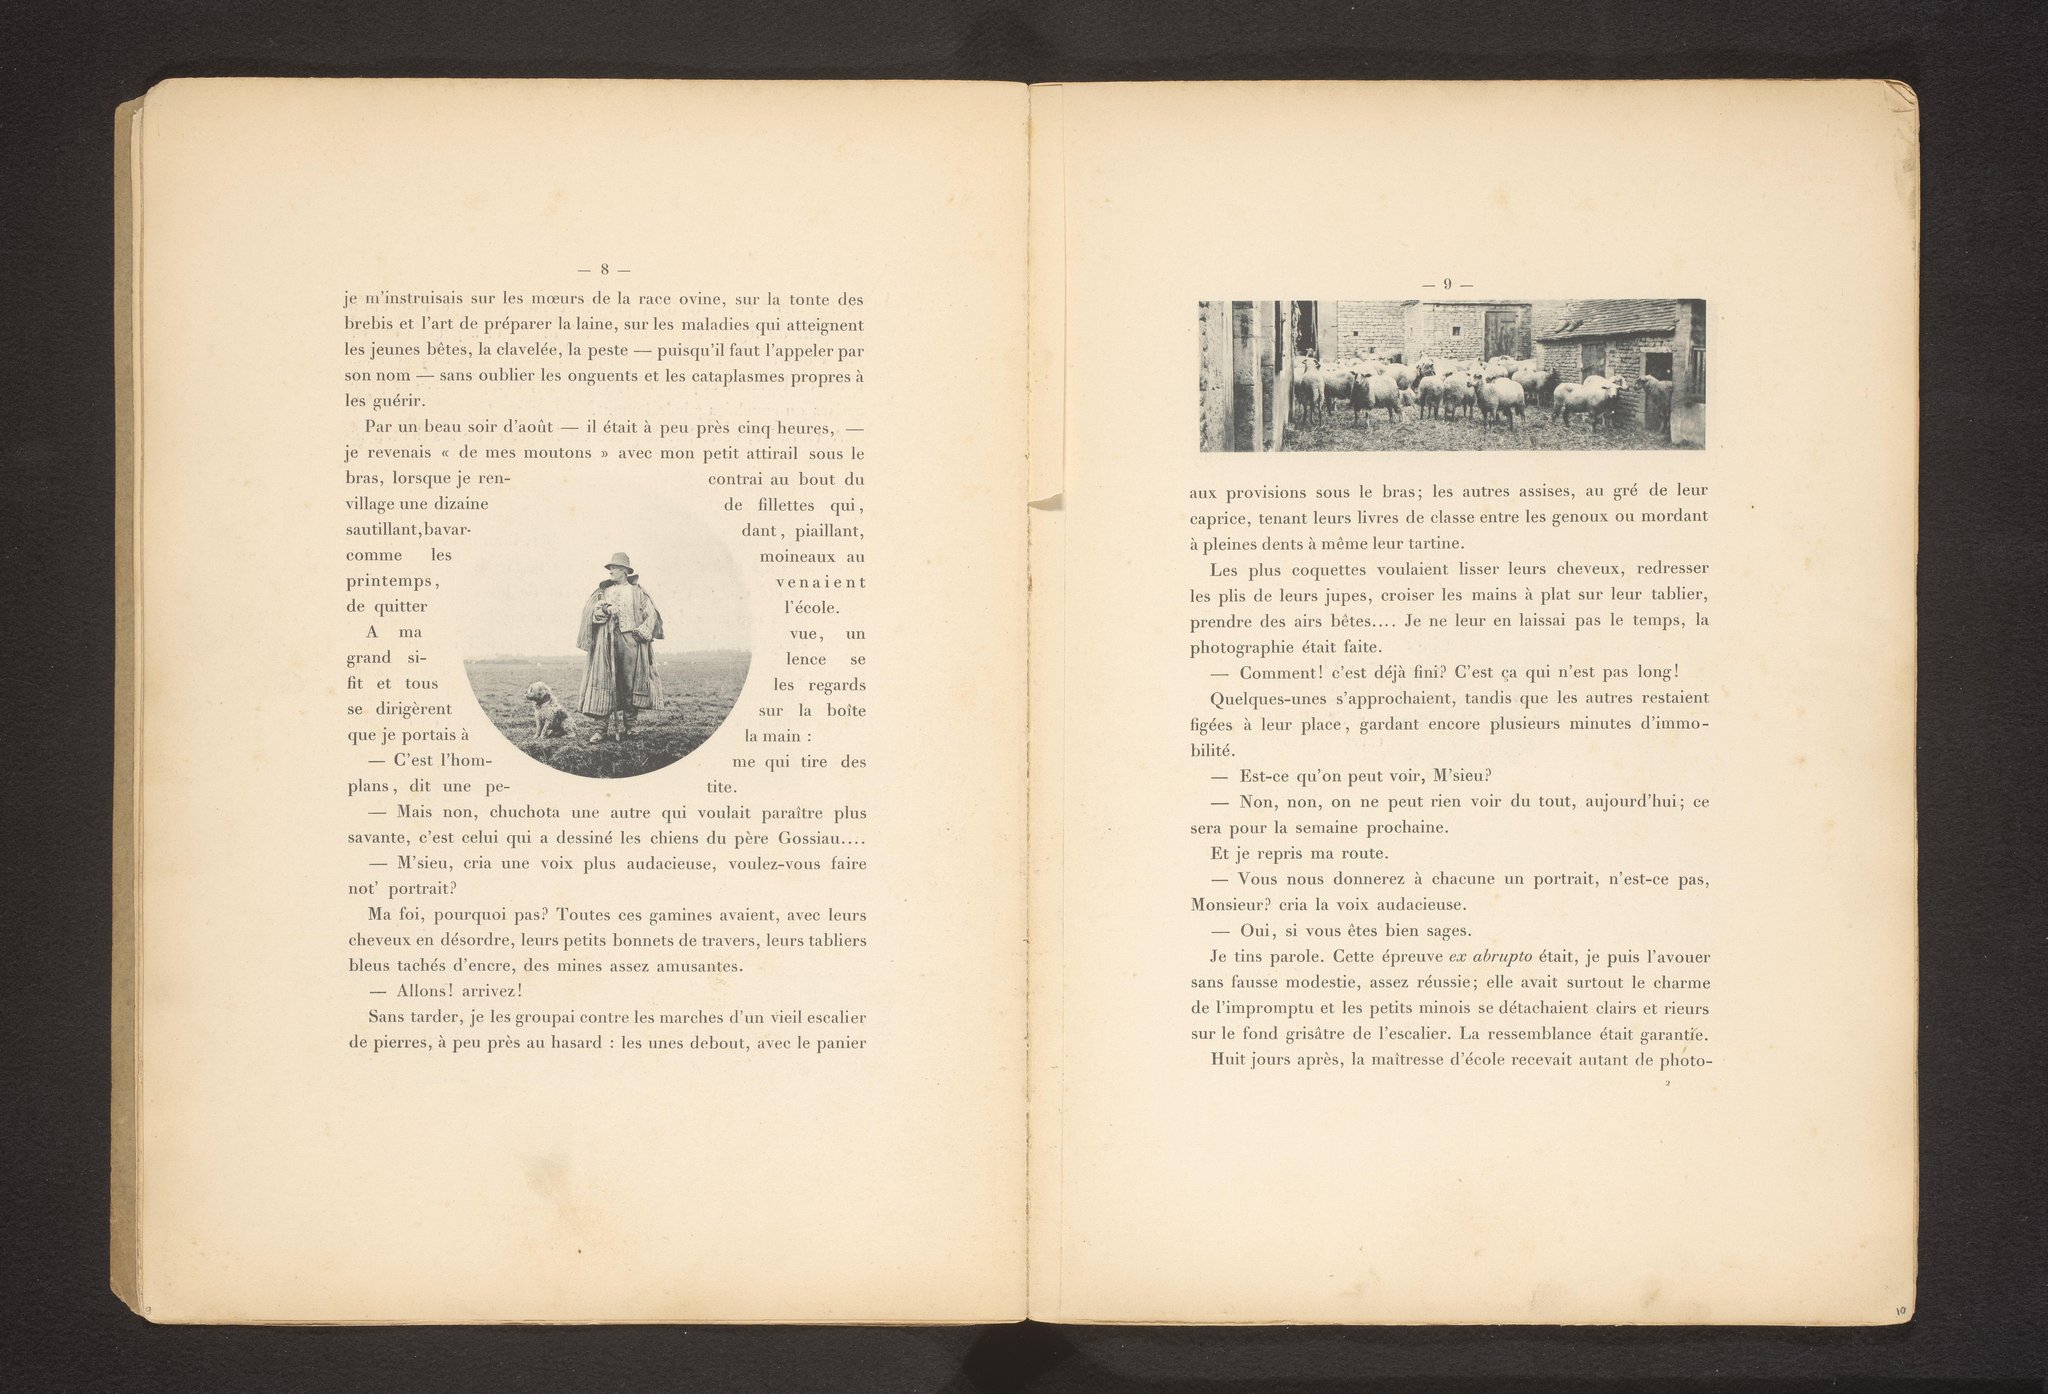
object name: page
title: Portret van een onbekende schaapherder met een hond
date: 1885-1895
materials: paper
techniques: photograph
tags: herding, herdsman, herdswoman, shepherd, shepherdess, cowherd, etc., dog